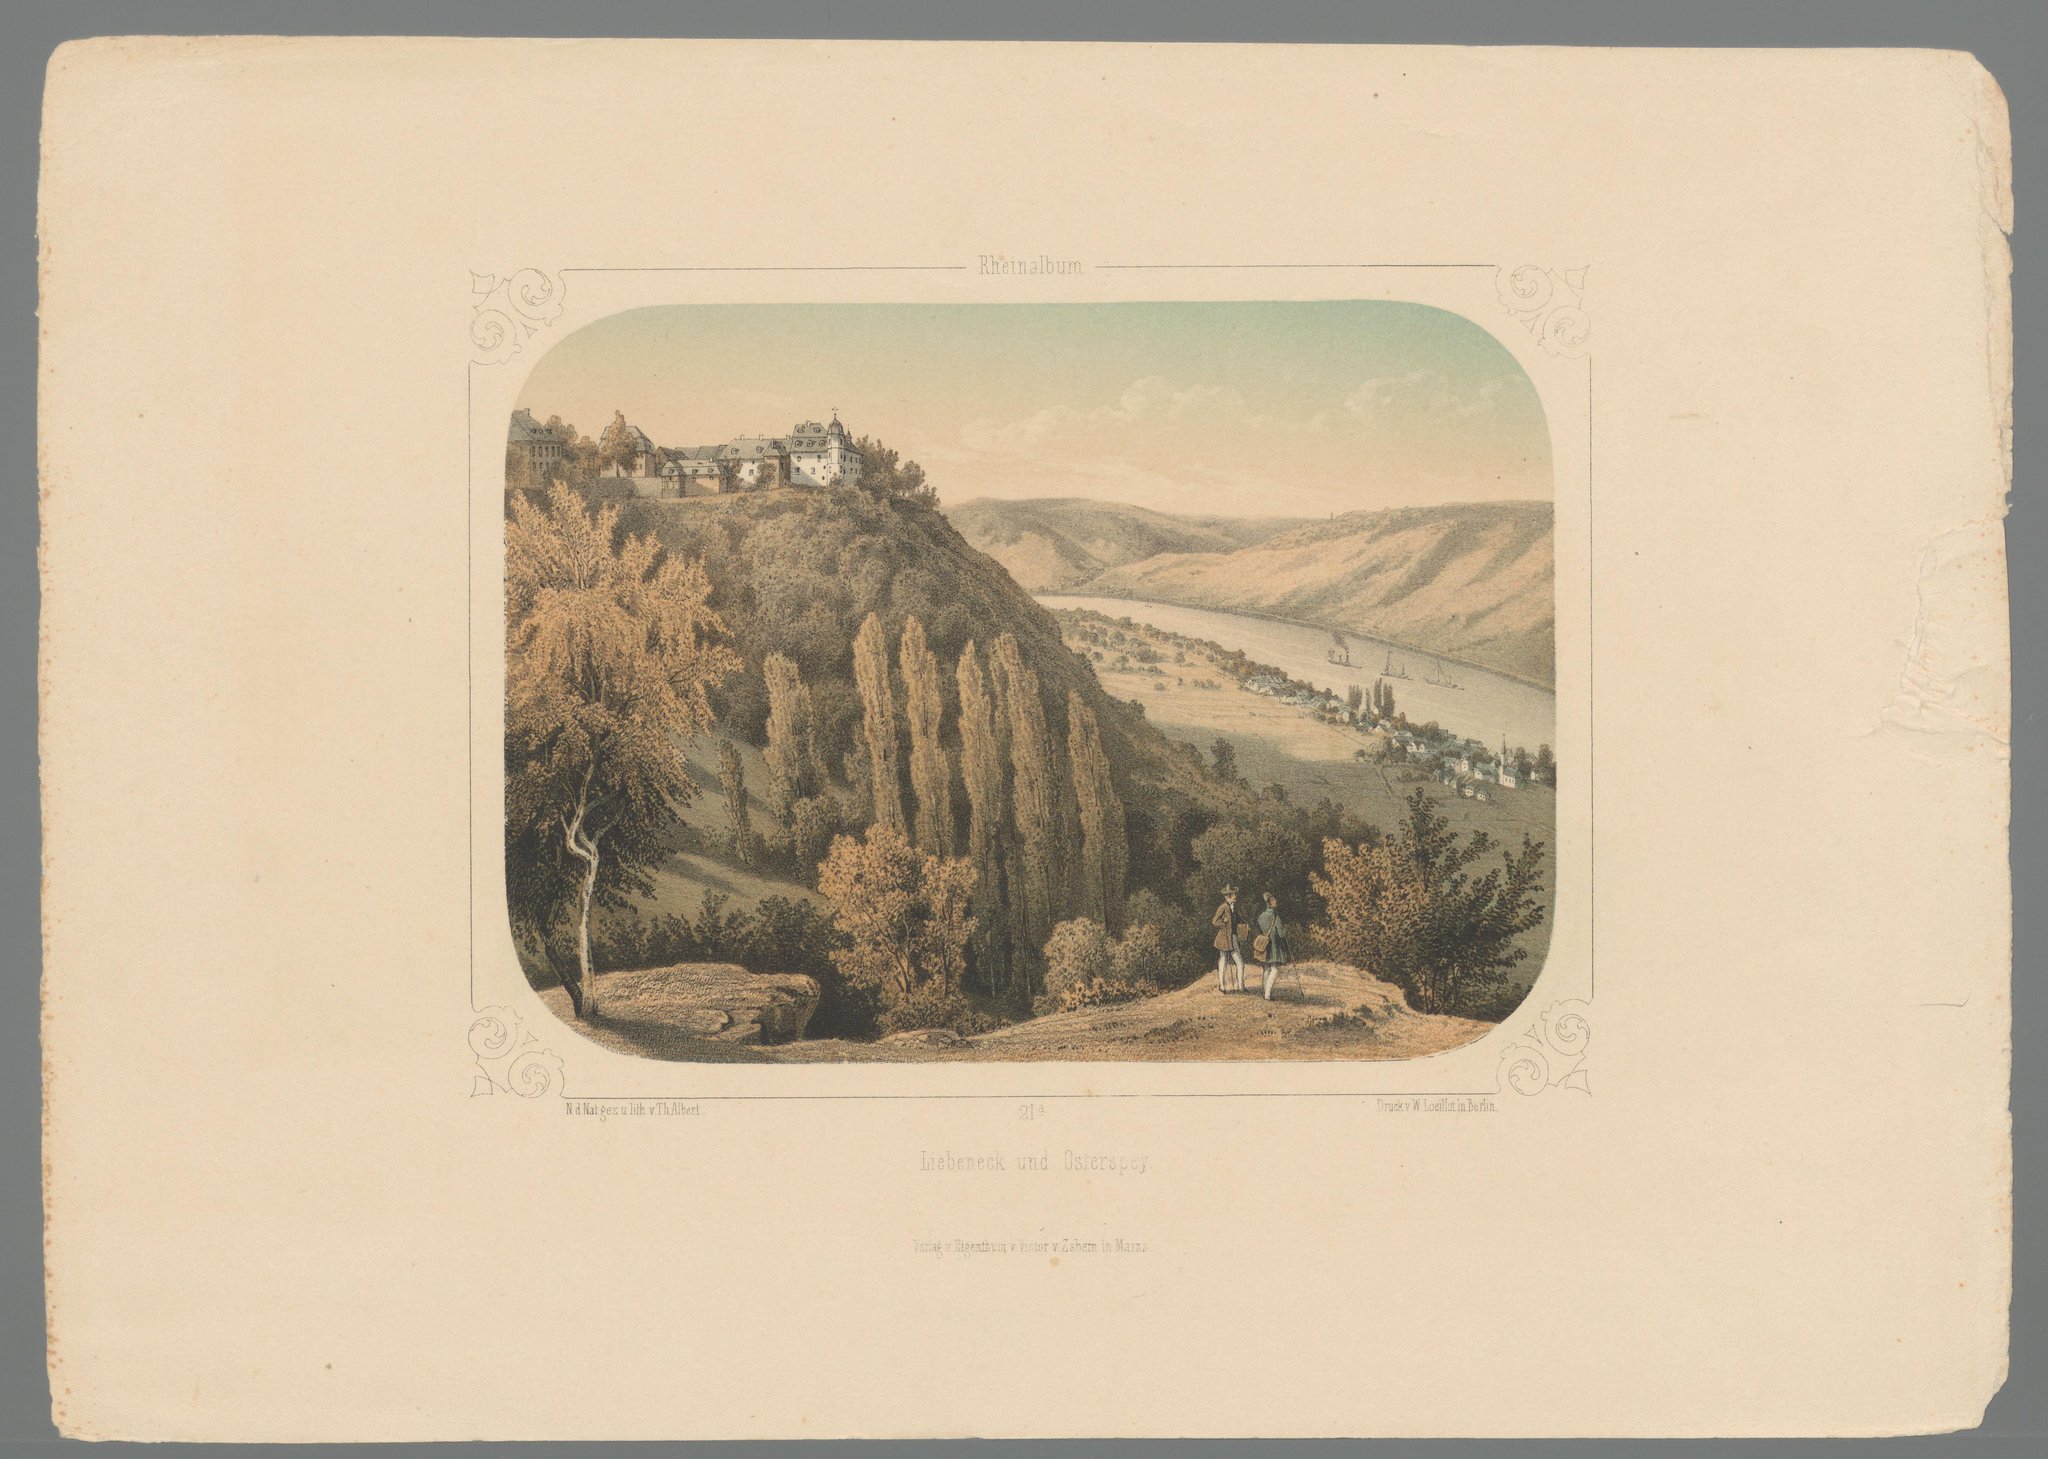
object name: print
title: Liebeneck ud Osterspey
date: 1858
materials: paper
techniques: lithograph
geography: mainz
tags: river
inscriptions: collector's mark: Lugt 2228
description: Prent maakt deel uit van een serie van 36 prenten, waarbij het eveneens mogelijk was deze te laten samenbinden tot een album.